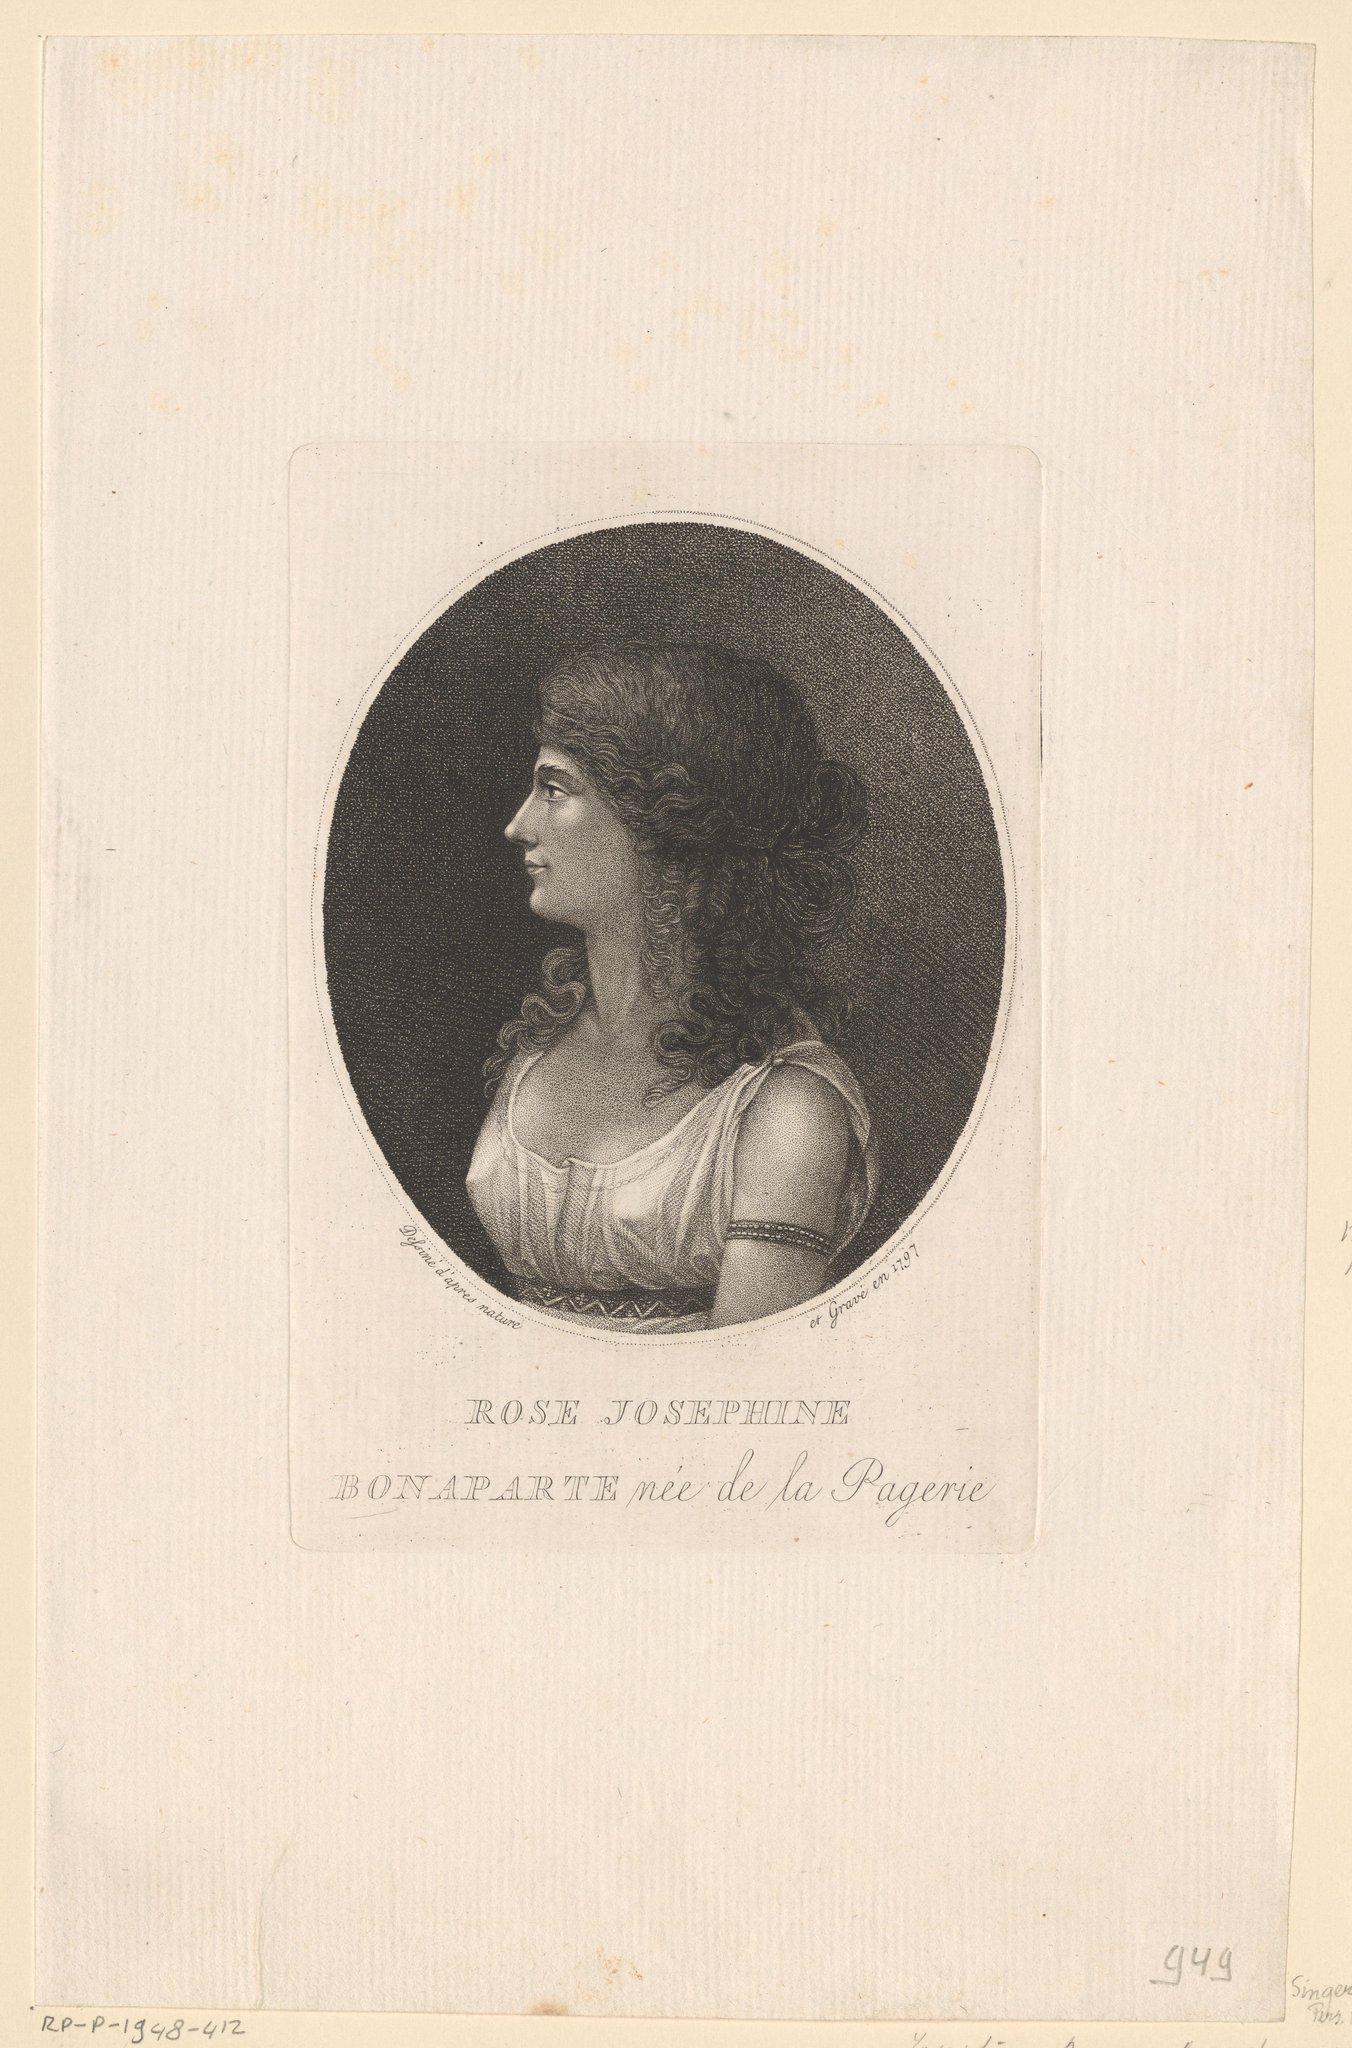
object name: print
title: Portret van Joséphine de Beauharnais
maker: Anonymous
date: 1797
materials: paper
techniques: engraving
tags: joséphine de beauharnais, historical persons - bb - woman, emperor - bb - female ruler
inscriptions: collector's mark: Lugt 2228